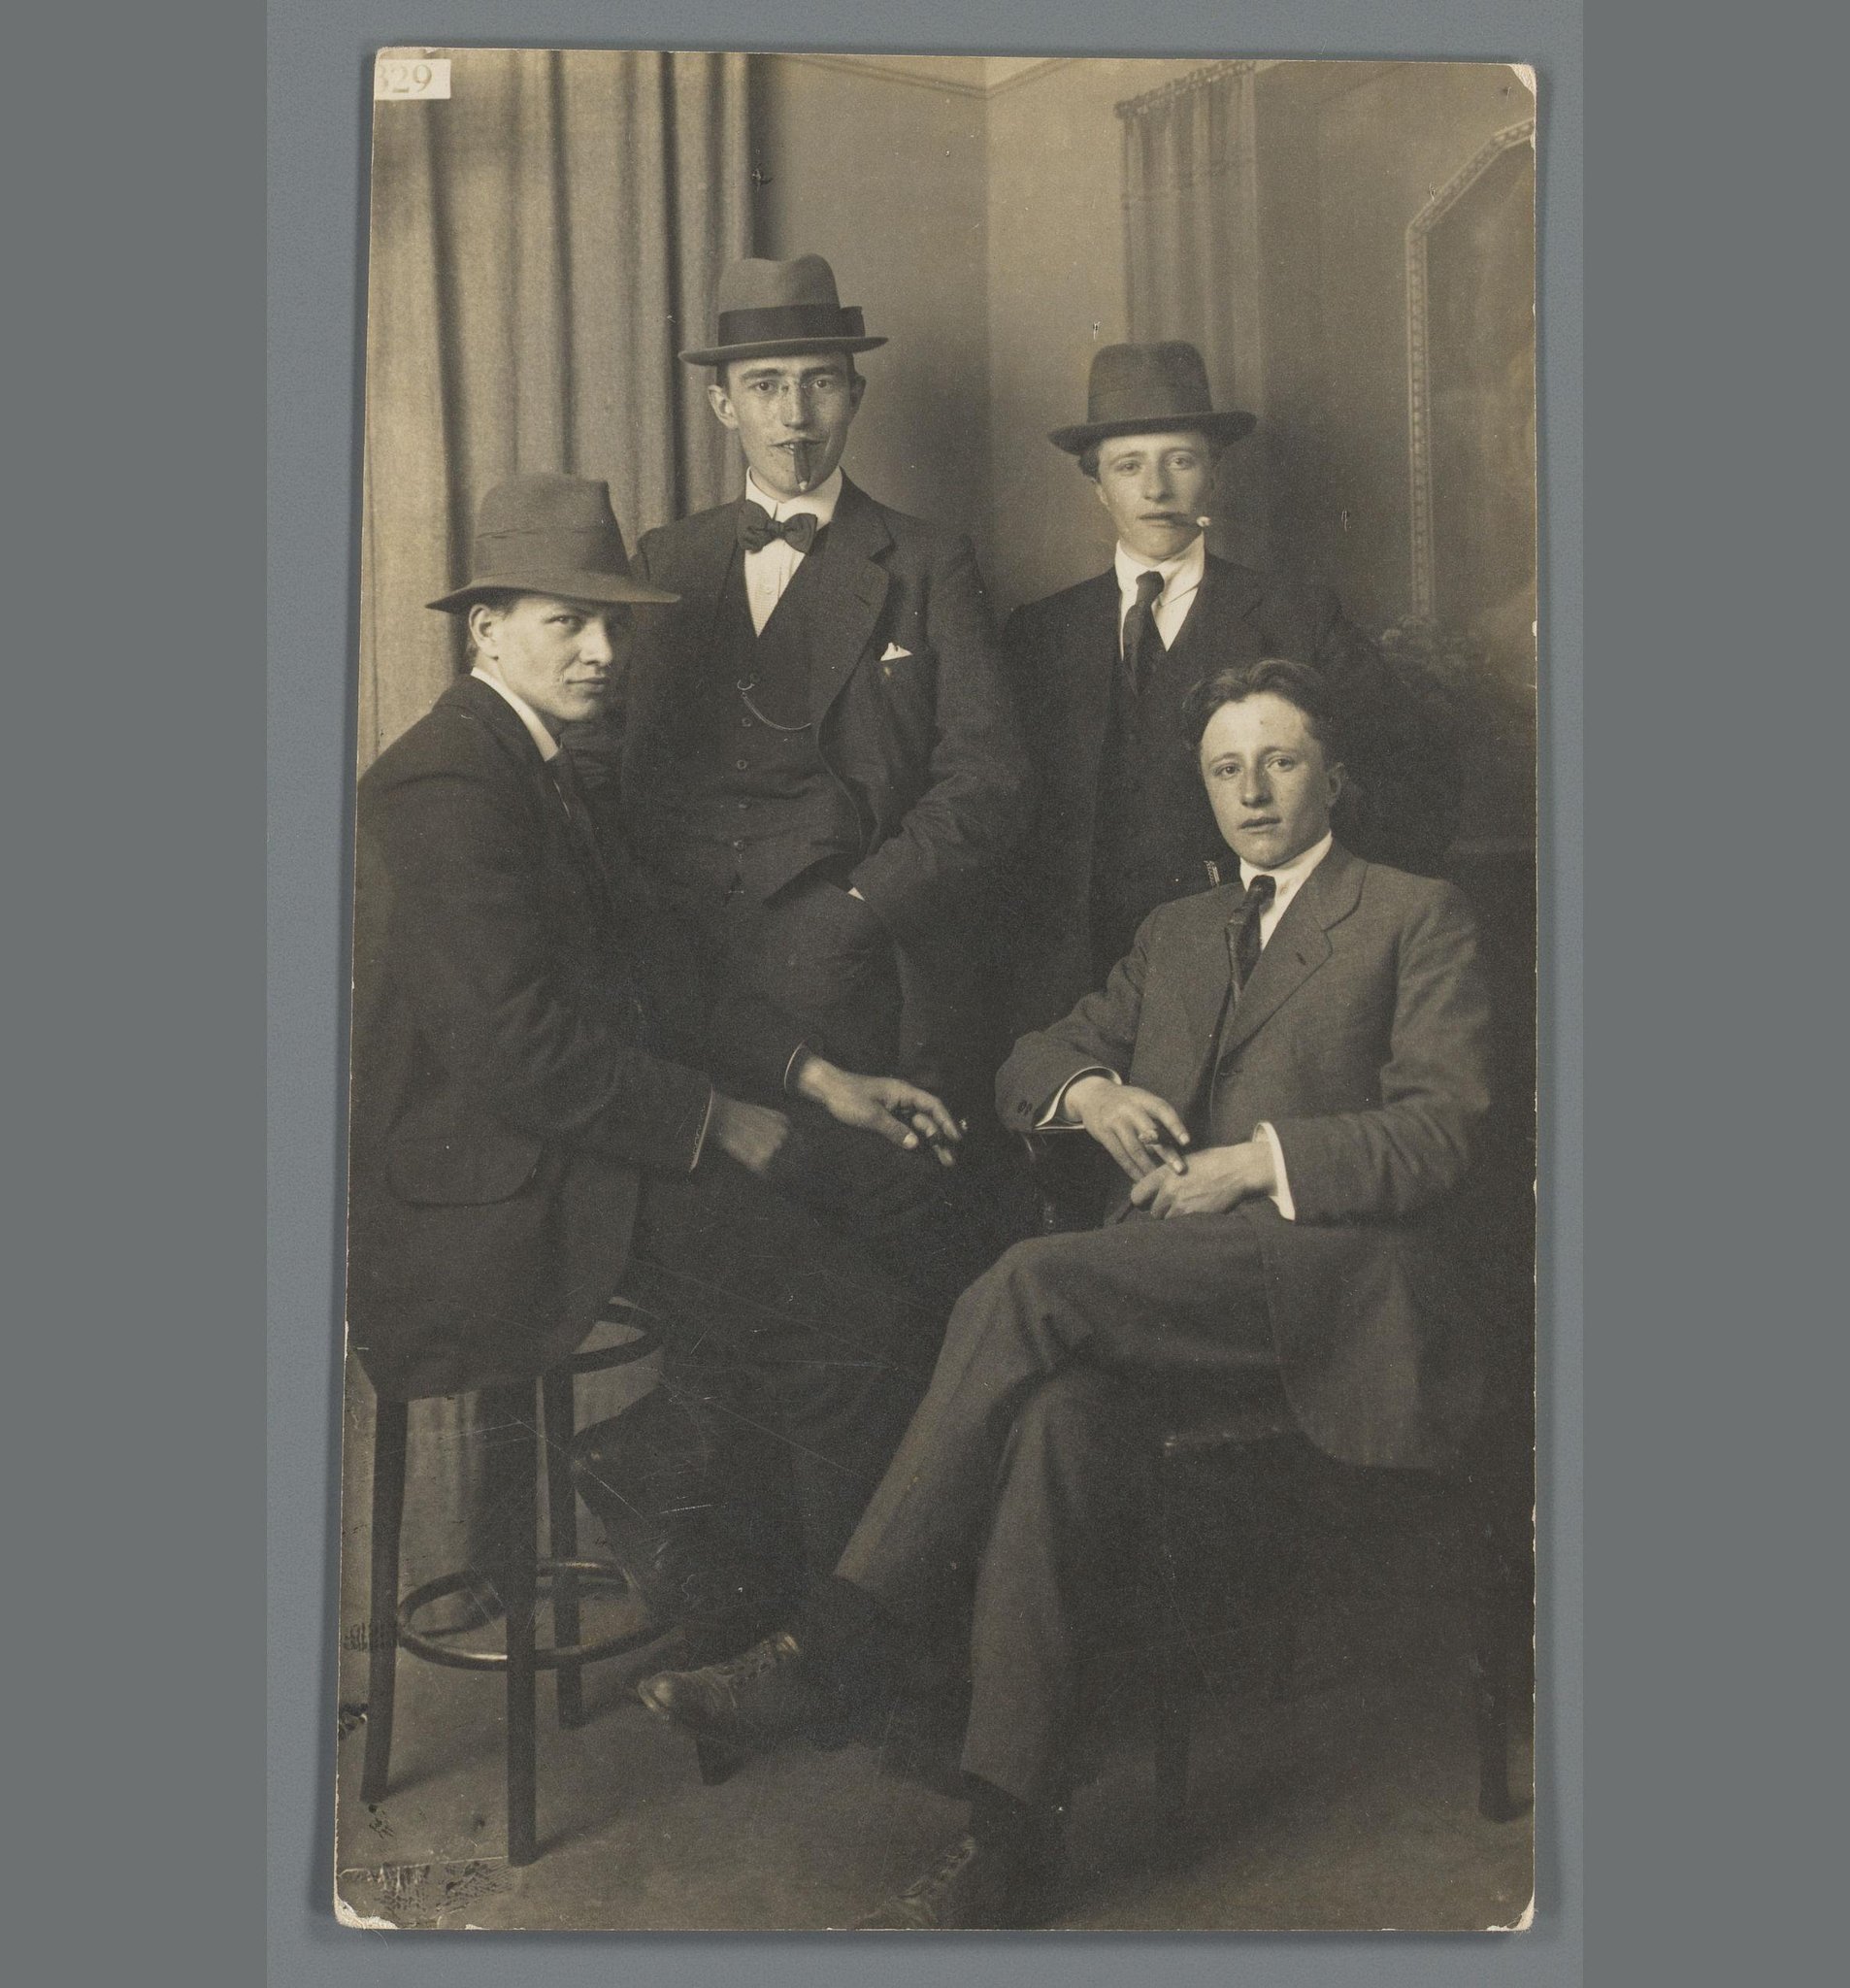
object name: photograph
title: Groepsportret van vier onbekende jonge mannen met sigaren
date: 1917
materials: paper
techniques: gelatin silver print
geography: groningen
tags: cigar, youth, adolescent, anonymous historical persons portrayed in a group, in a group-portrait